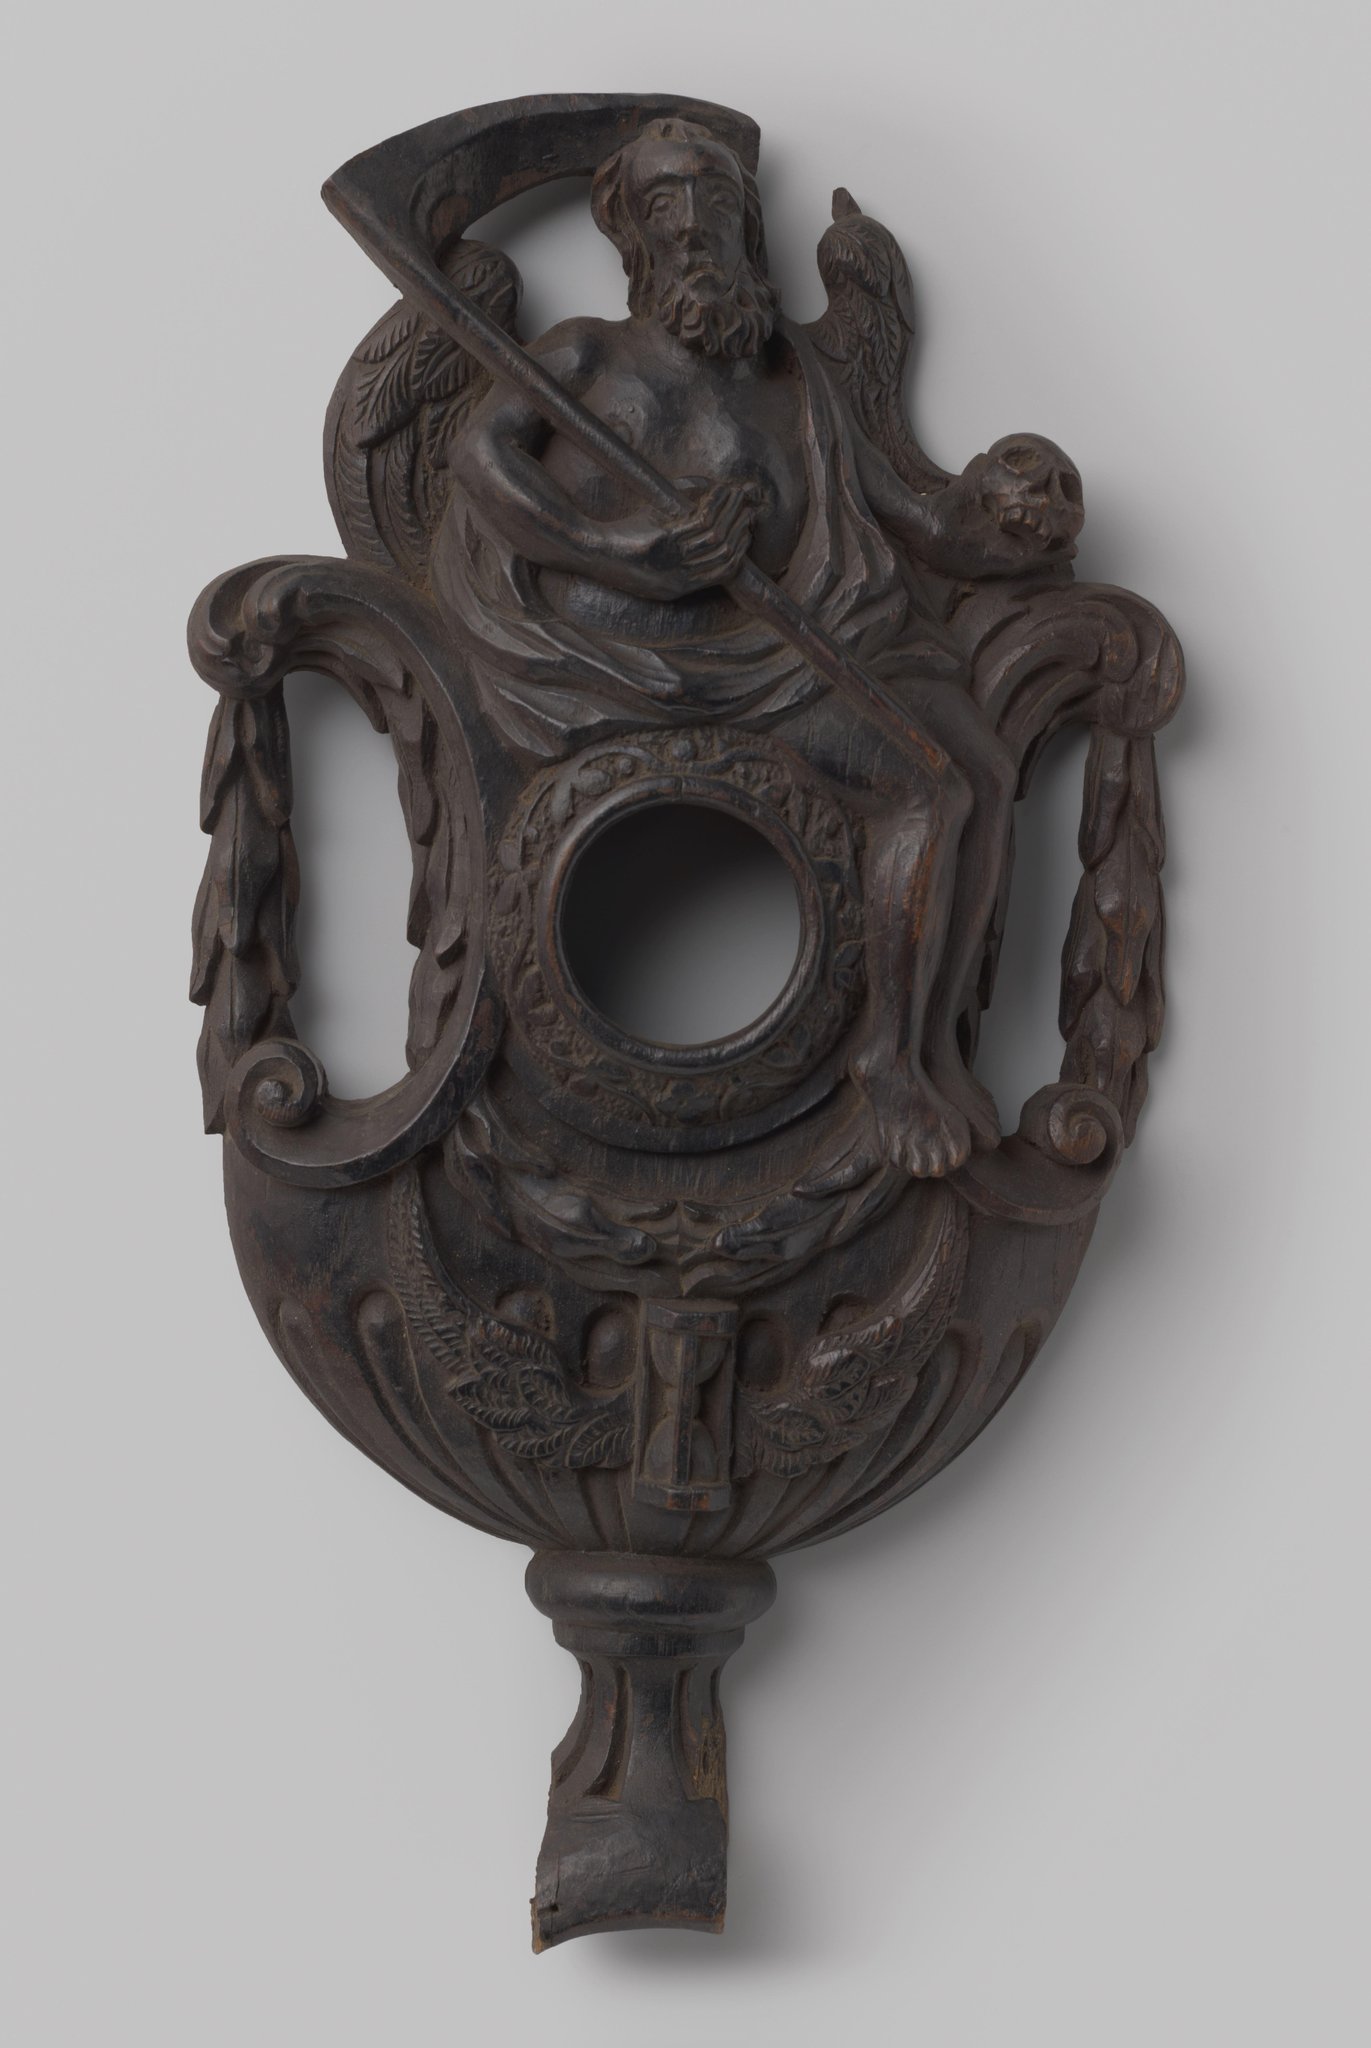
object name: woodcarving visual work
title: Bouwfragment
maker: Anonymous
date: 1700-1800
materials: wood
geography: netherlands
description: Eikenhouten snijwerk, zwart gebeitst afkomstig van een klein uurwerk. Bokaalvormig met rond gat voor uurwerk. De voorstelling is een allegorie op de vergankelijkheid of de dood. Engel met doodshoofd, zeis en zandloper opgesierd met guirlande's